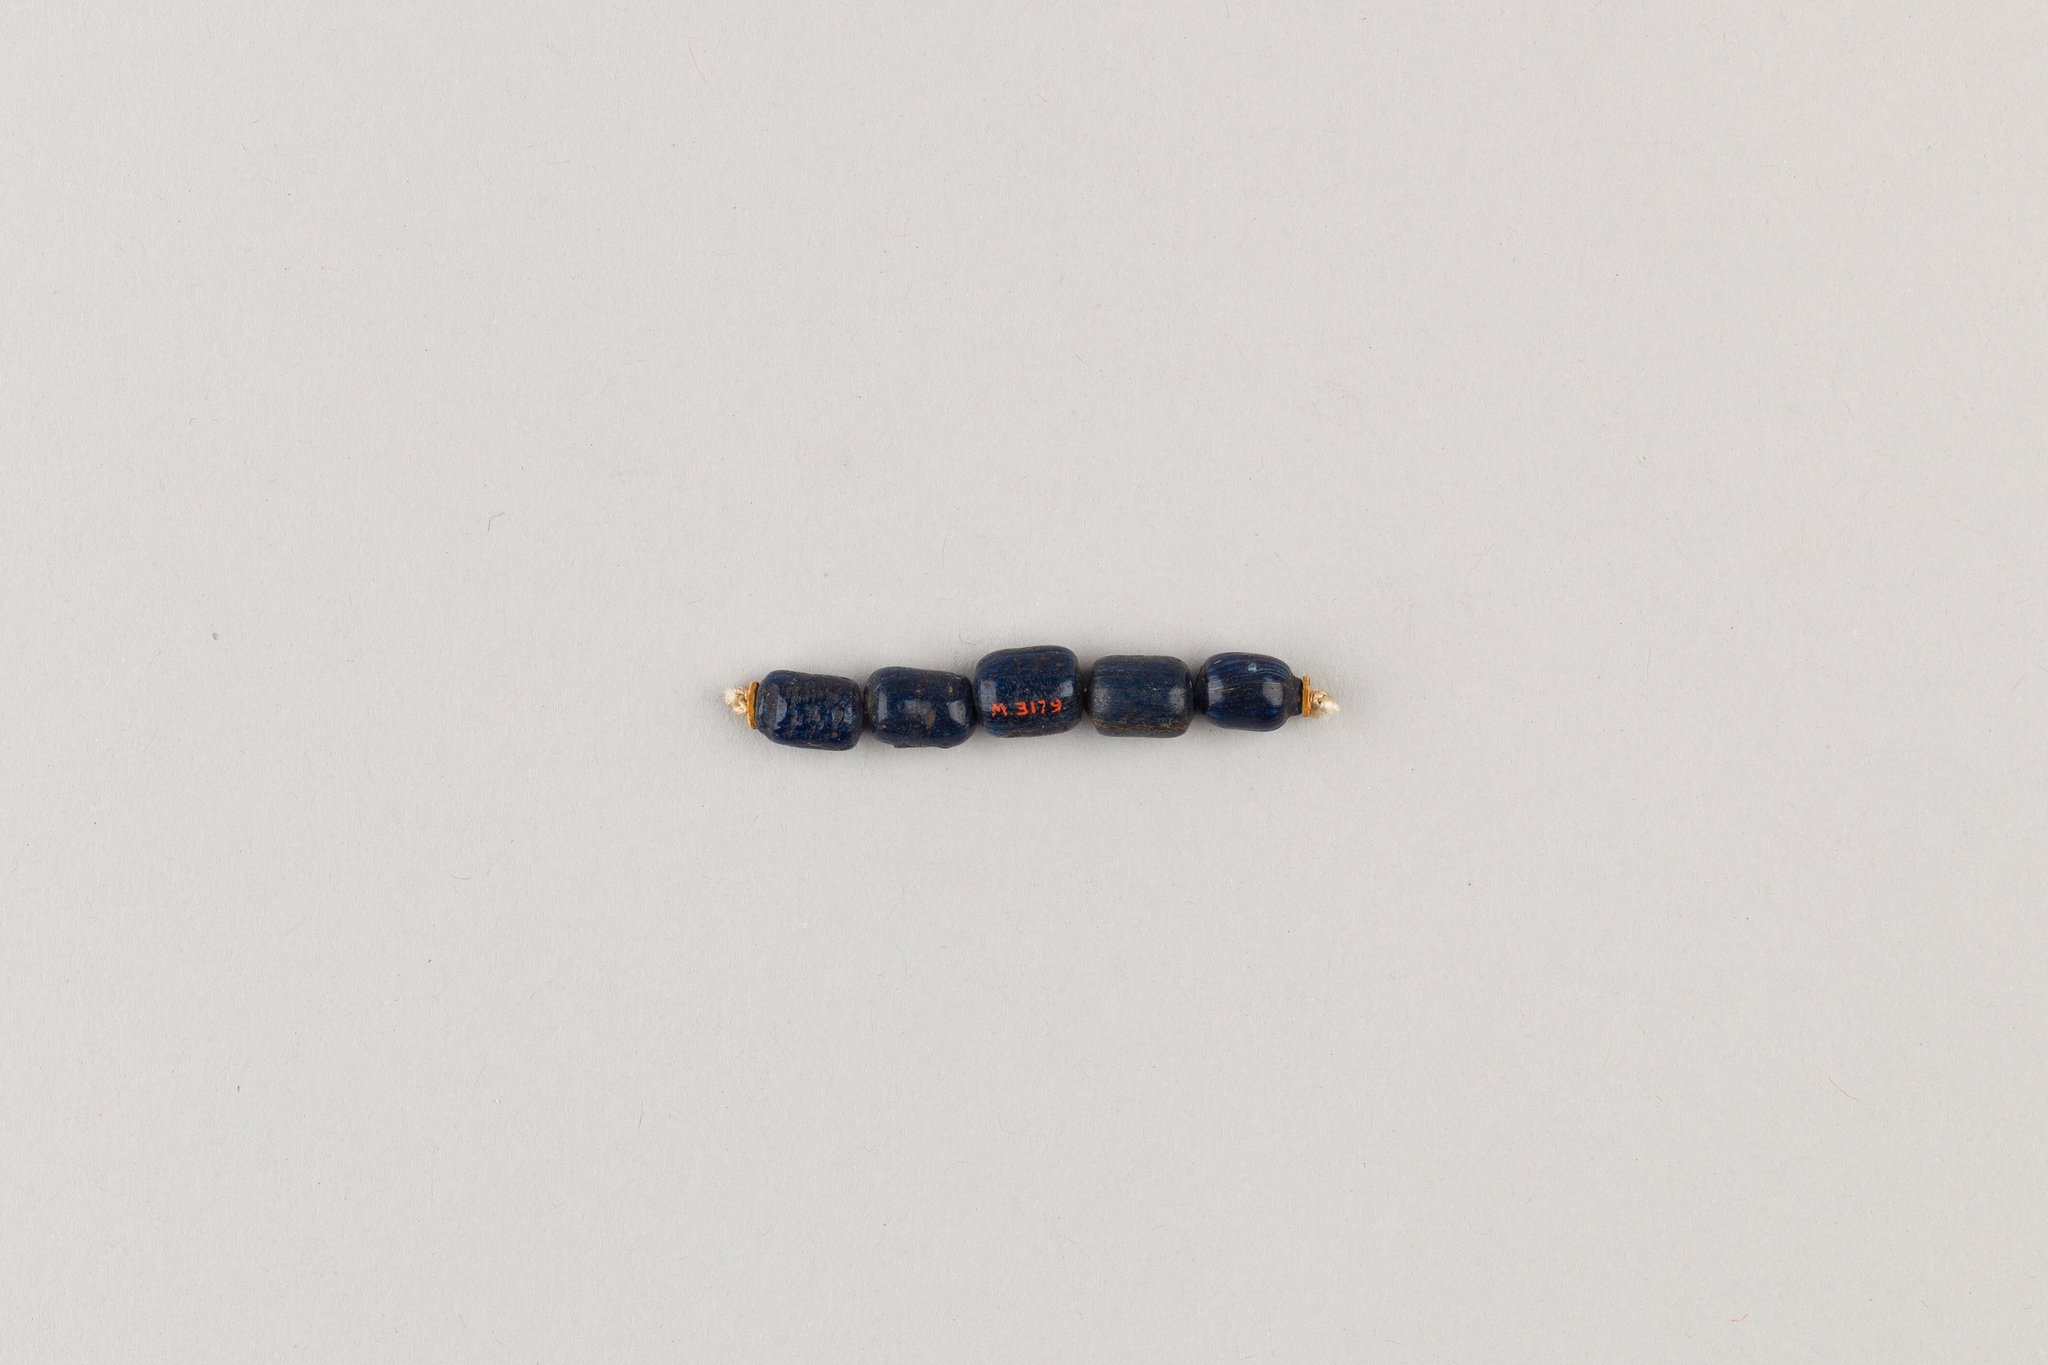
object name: bead, string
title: String of 5 bugle beads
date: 1-100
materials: glass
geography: egypt